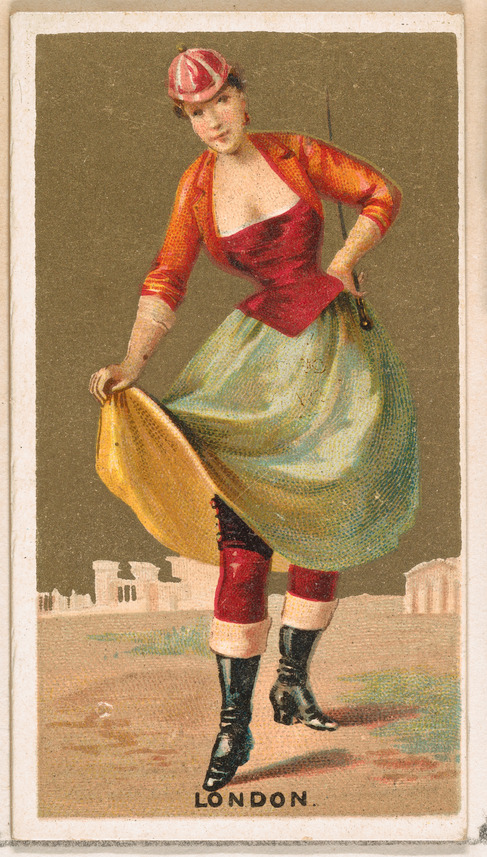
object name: print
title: London, from the Dancing Girls of the World series (N185) issued by Wm. S. Kimball & Co.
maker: william s. kimball & company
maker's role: publisher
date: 1889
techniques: color lithograph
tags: women,dancing